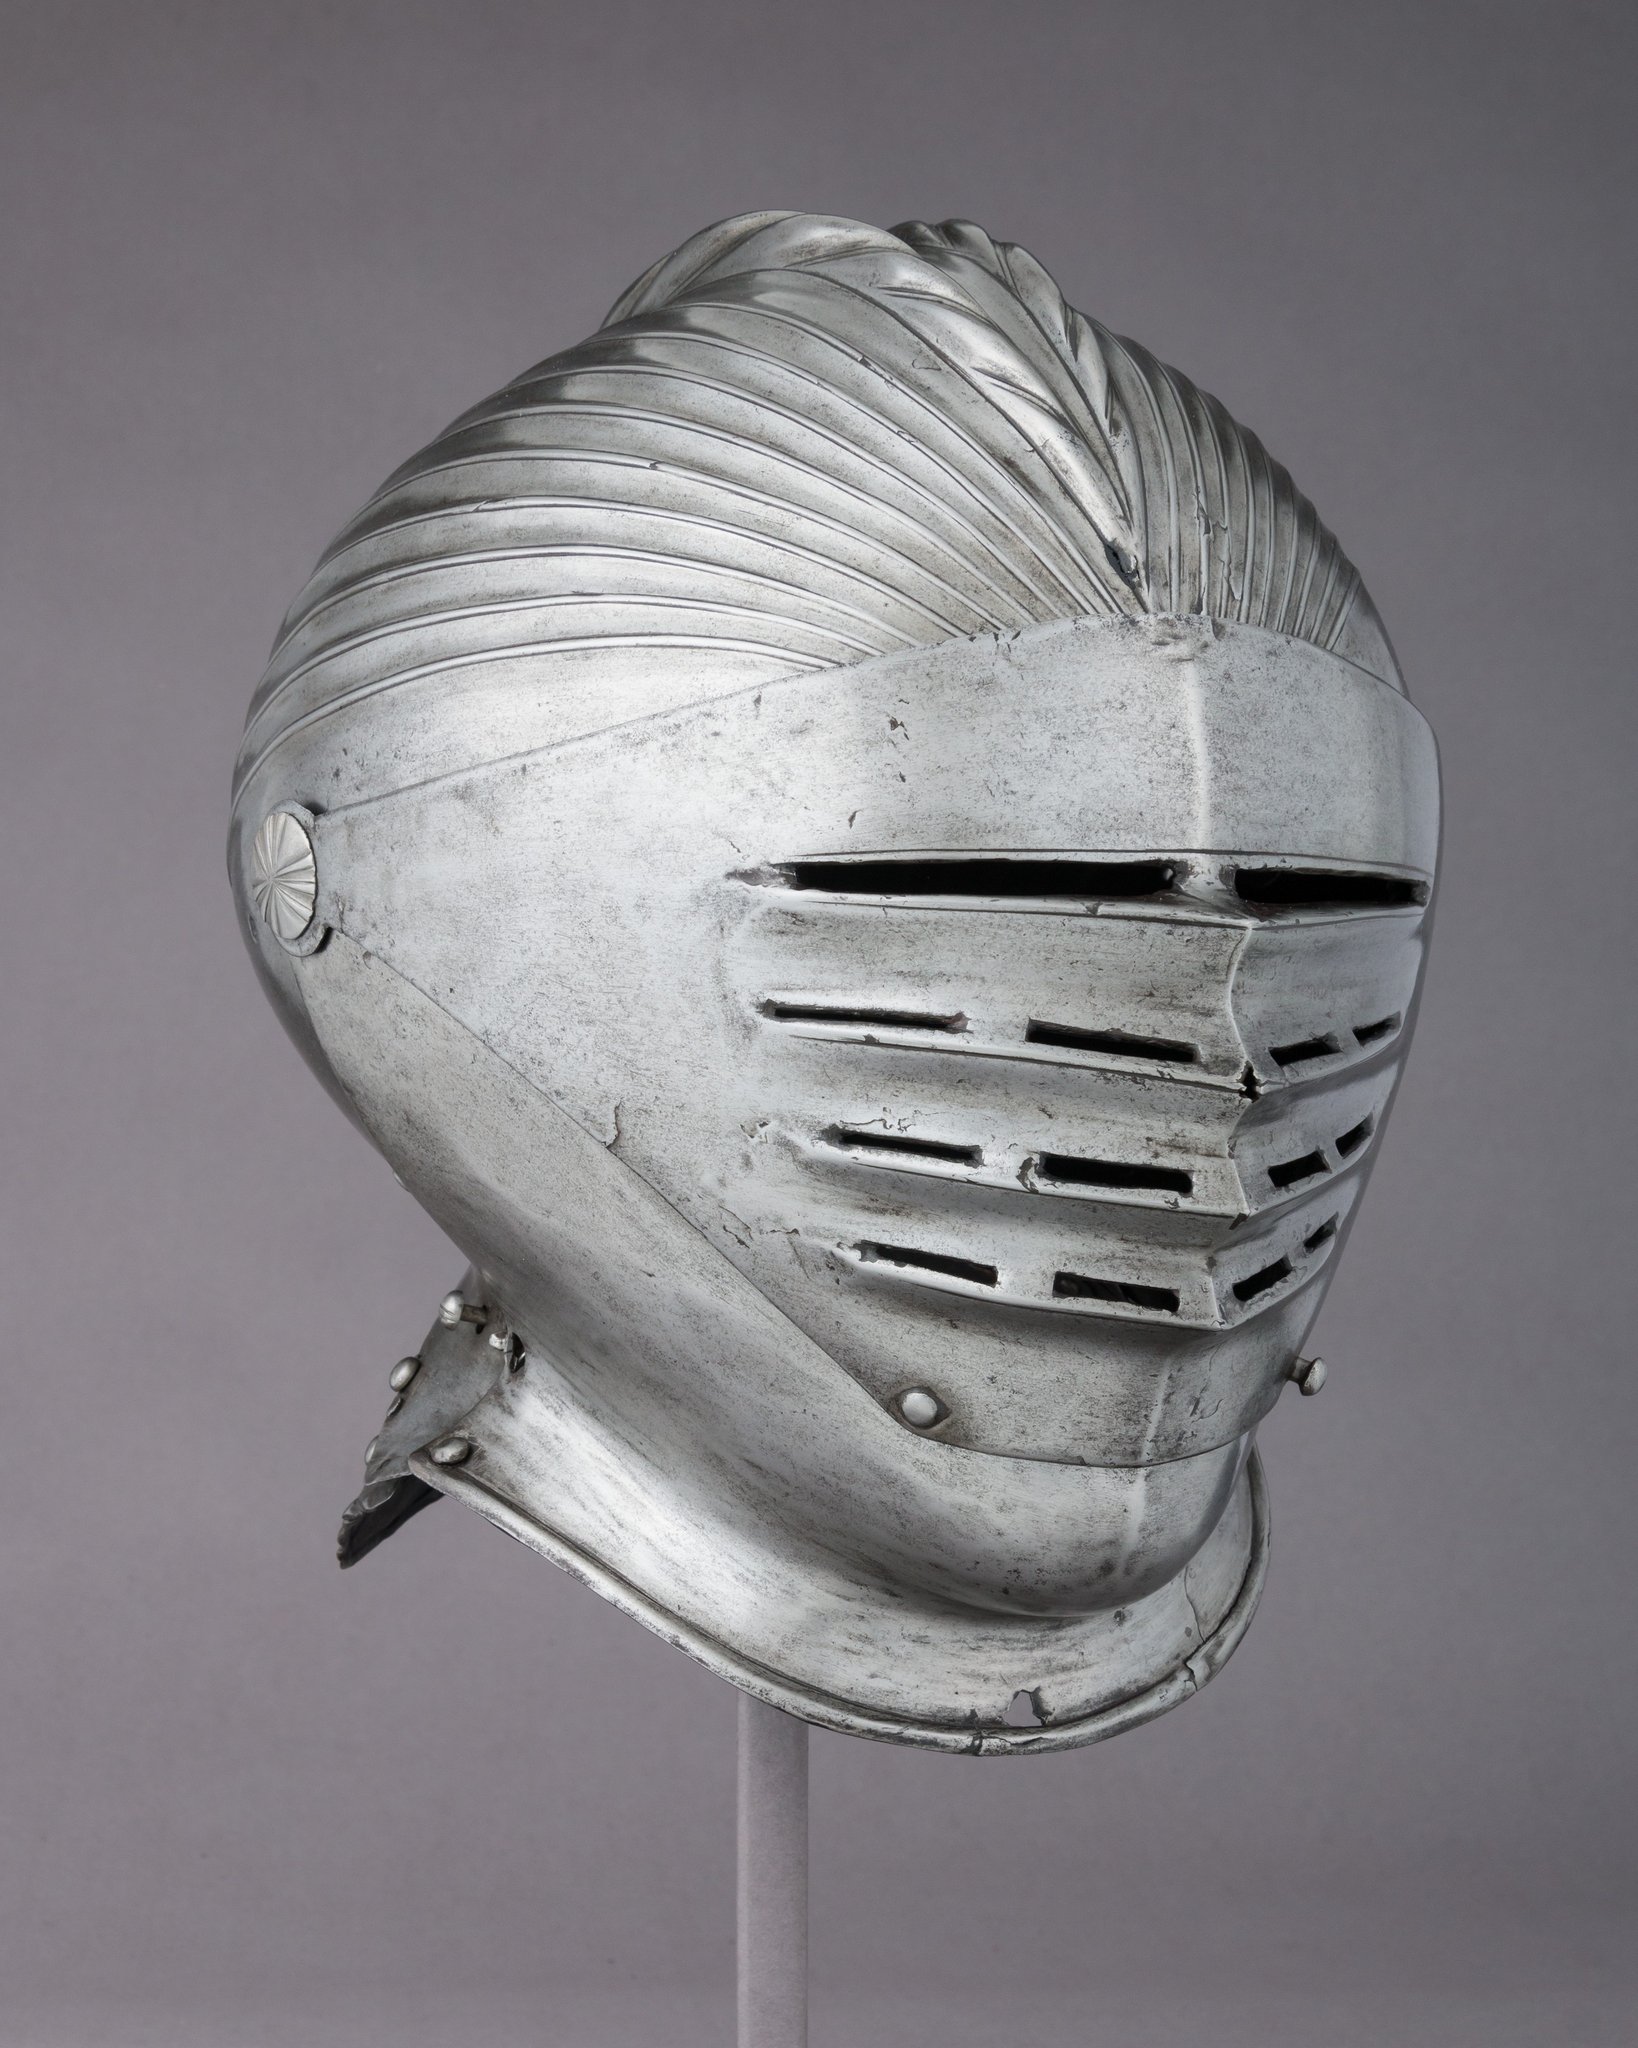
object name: double crested maximilian helmet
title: Double-Crested Maximilian Helmet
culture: german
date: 1520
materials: steel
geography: germany